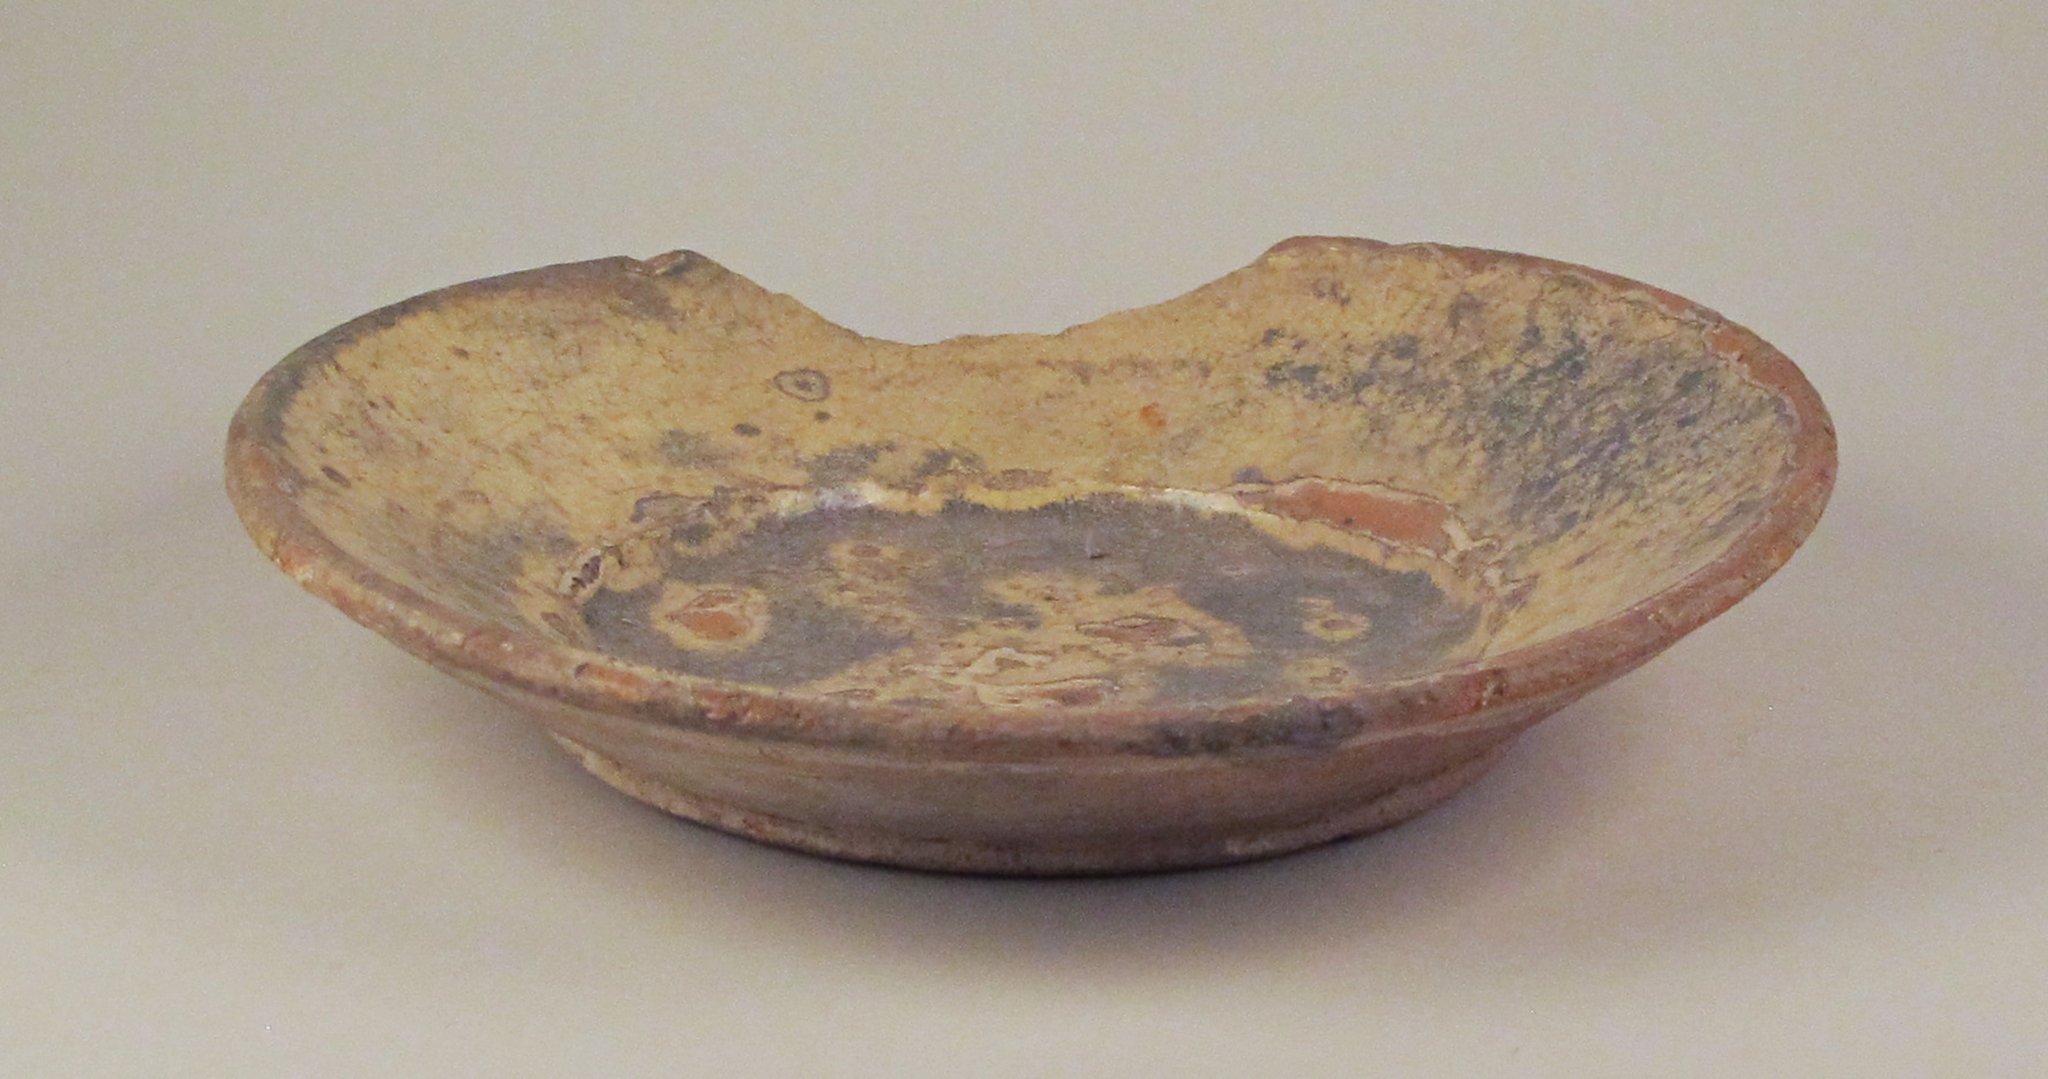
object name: plate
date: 7000 BCE-330 CE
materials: terracotta